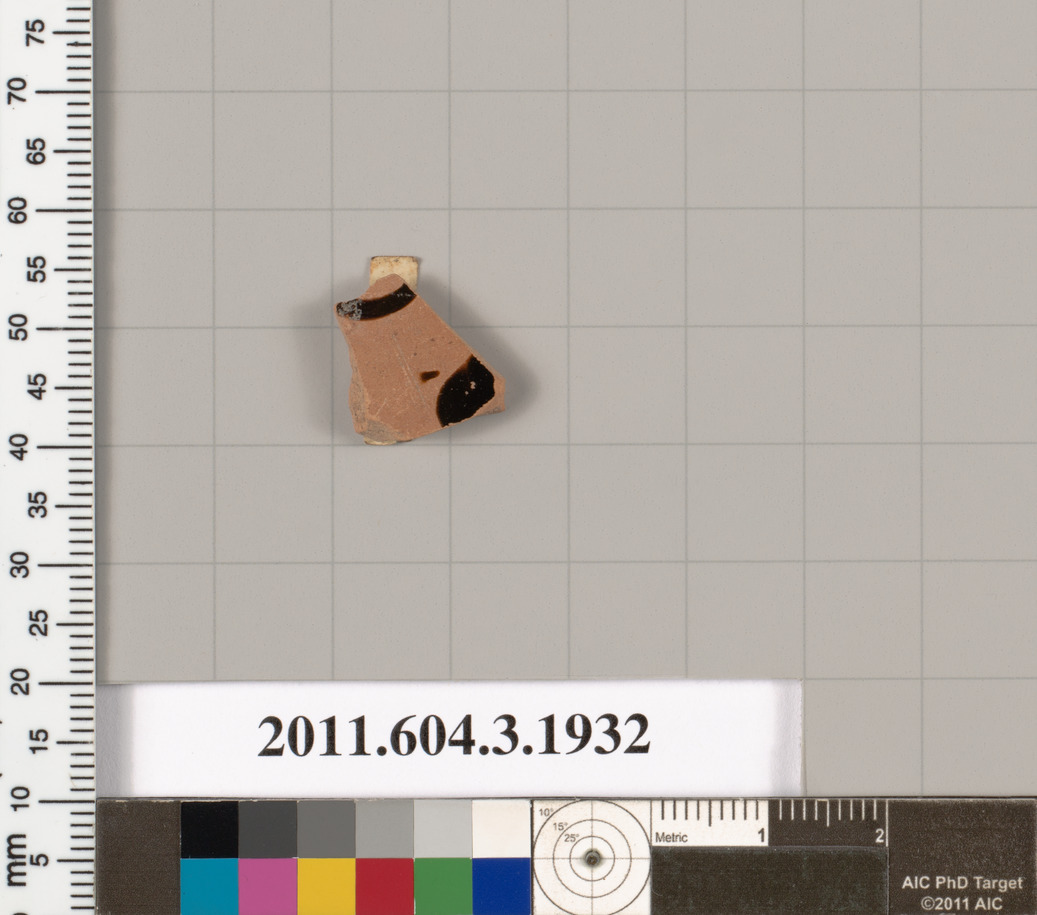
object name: kylix or skyphos fragment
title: Terracotta fragment of a kylix (drinking cup) or a skyphos (deep drinking cup)?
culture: greek, attic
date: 534-468 BCE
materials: terracotta